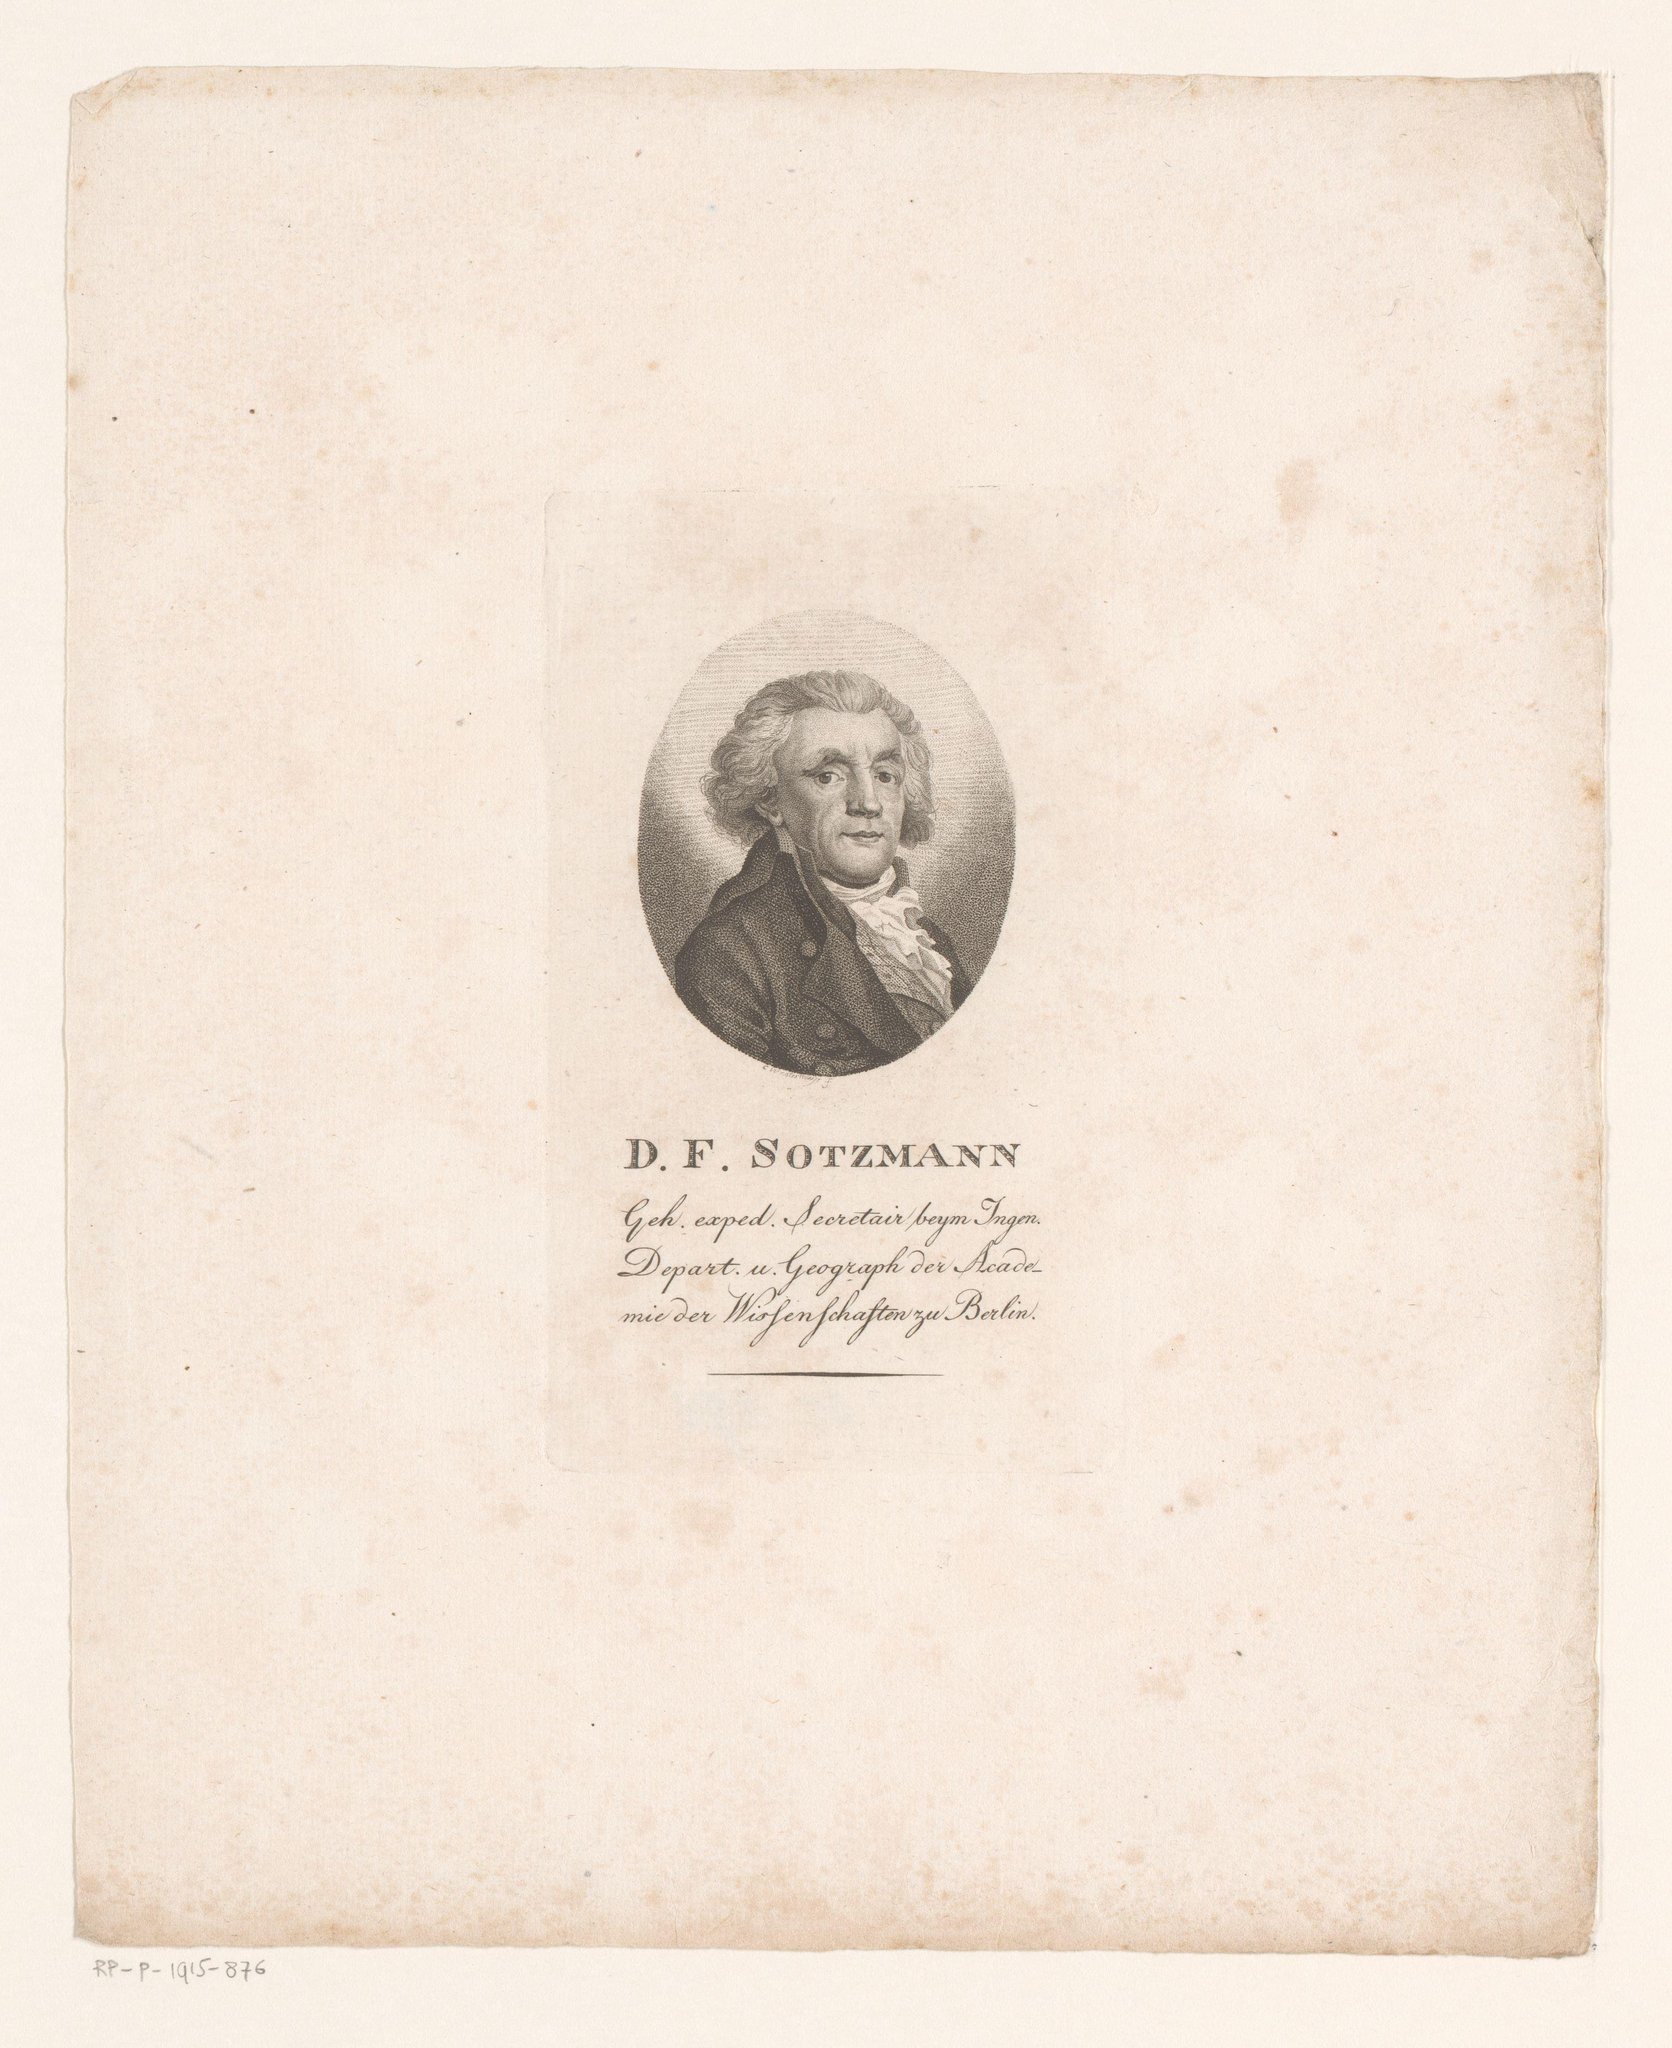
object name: print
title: Portret van Daniel Friedrich Sotzmann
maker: konrad westermayr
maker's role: print maker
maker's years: 1765-1834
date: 1775-1834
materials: paper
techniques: engraving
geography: germany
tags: berlin, historical persons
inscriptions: collector's mark: Lugt 2228